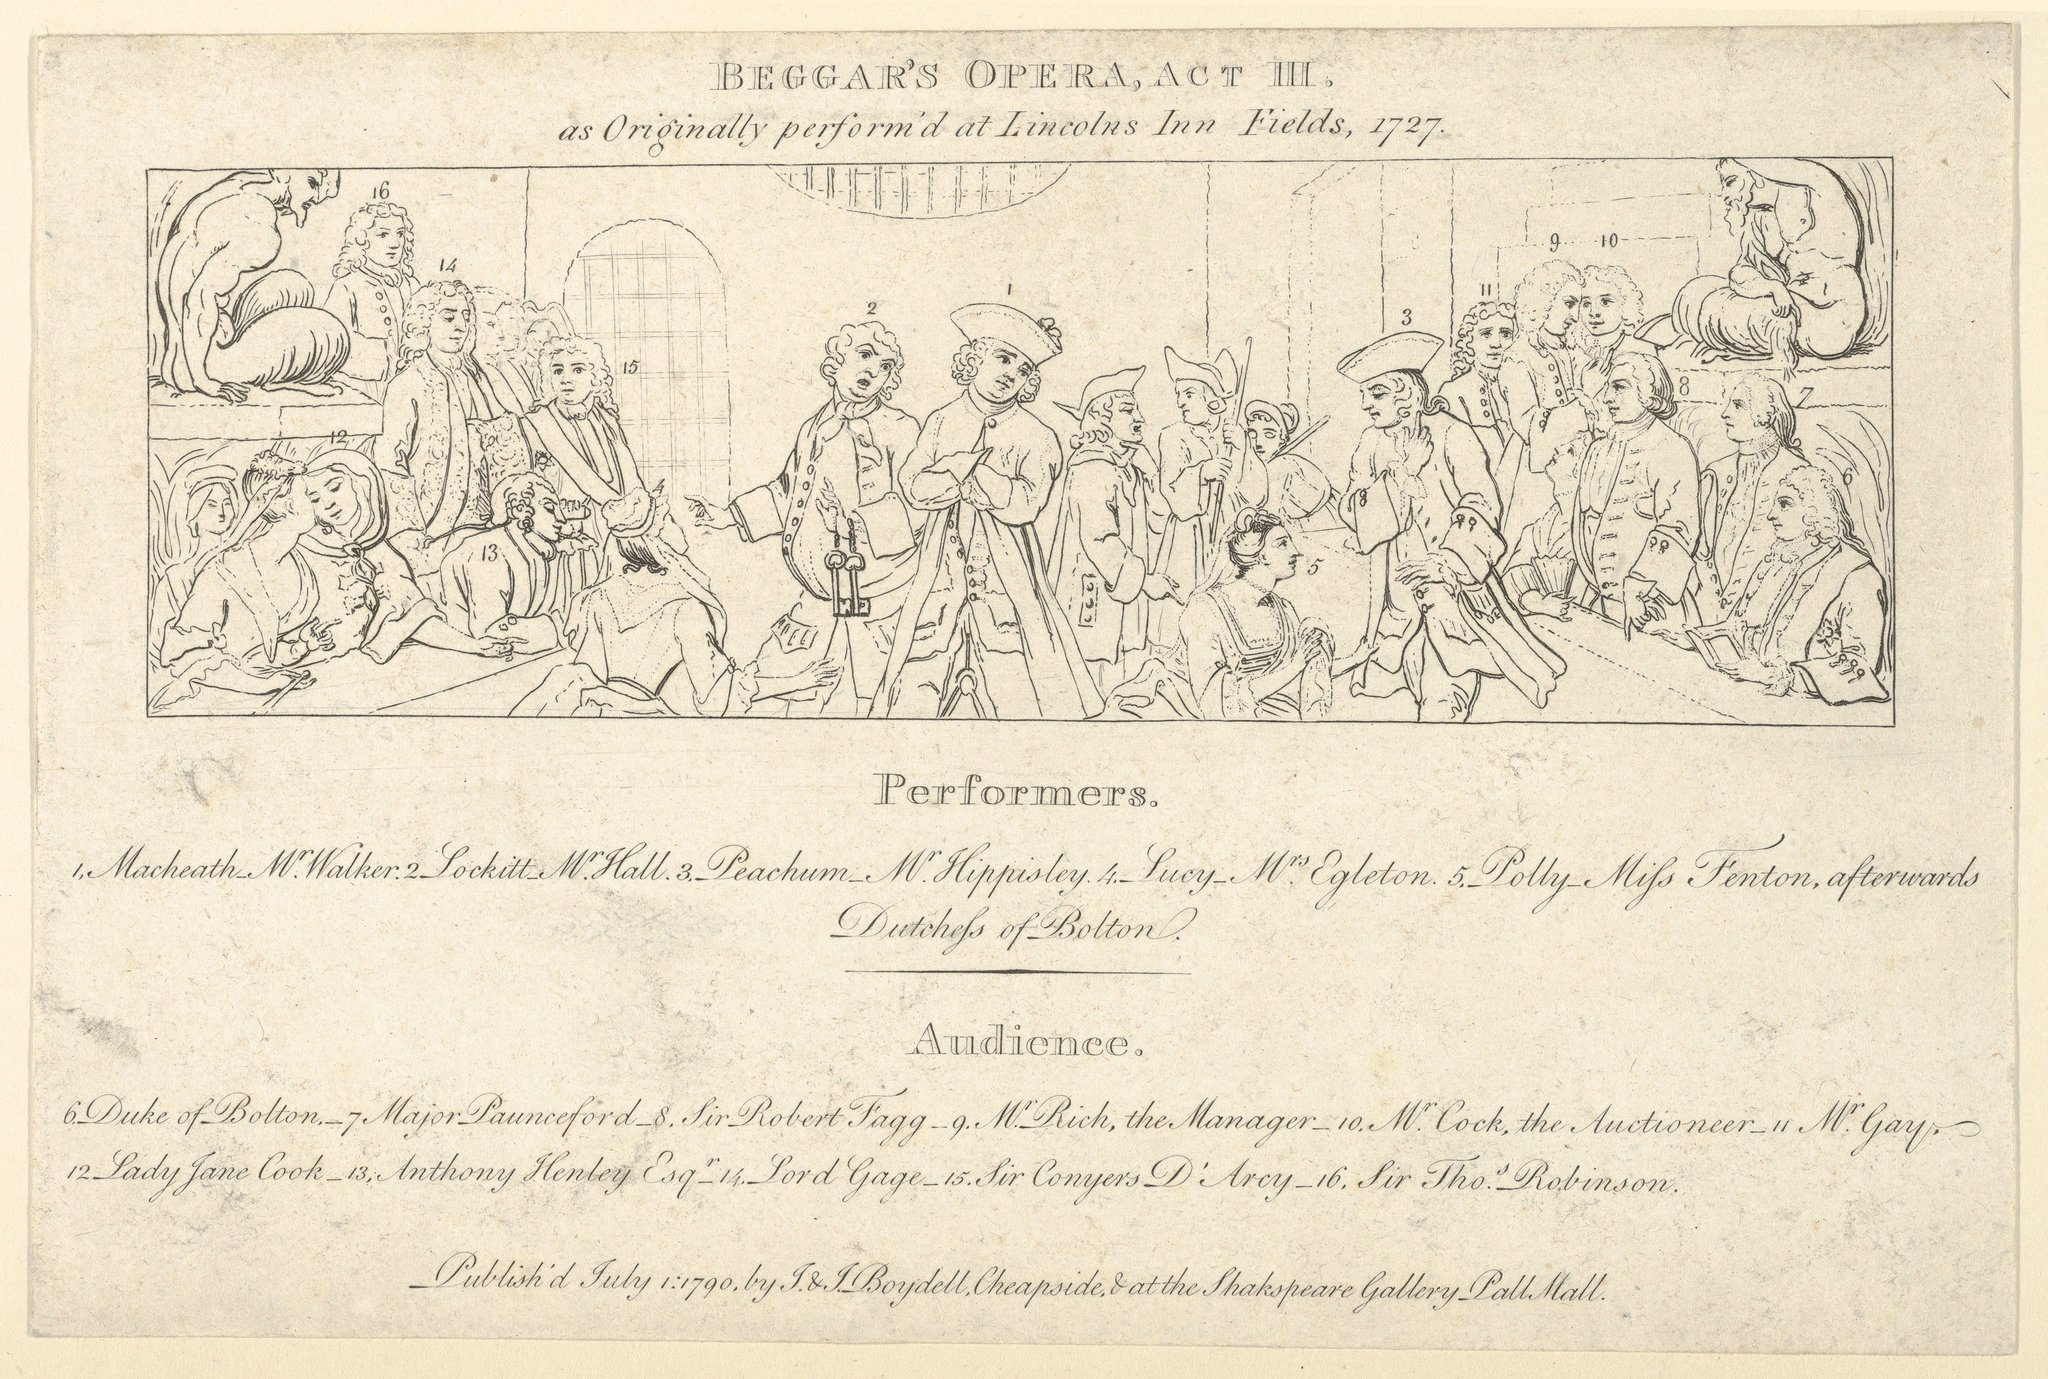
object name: print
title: Key with List of Performers and Audience to: The Beggars Opera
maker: william hogarth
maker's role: artist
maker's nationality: british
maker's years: 1697-1764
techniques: engraving, etching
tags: opera,performance,men,women